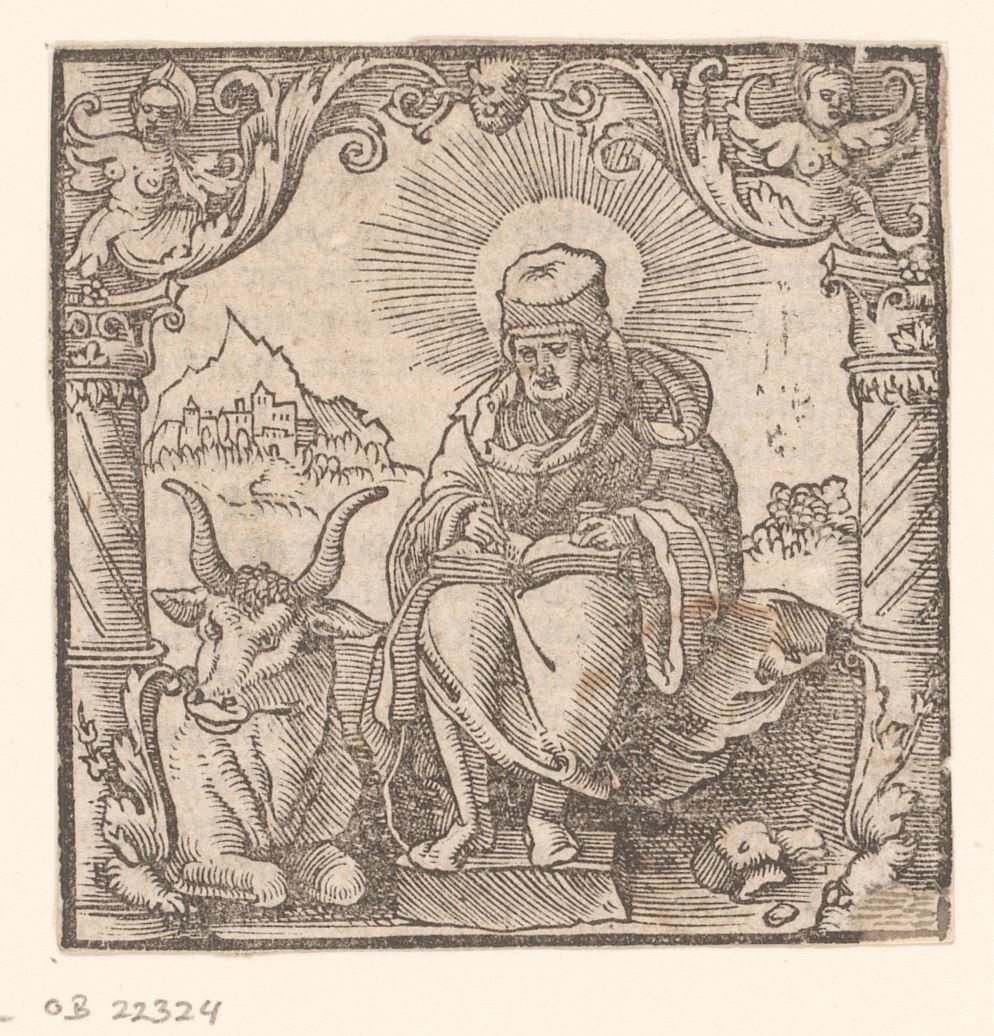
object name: print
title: Evangelist Lukas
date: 1529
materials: paper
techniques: woodcut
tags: luke the evangelist; possible attributes: book, (winged) ox, portrait of the virgin, surgical instruments, painter's utensils, scroll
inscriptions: collector's mark: Lugt 240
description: Prent gebruikt in: Das gantz new Testament. Keulen: Peter Quentel, 1529.